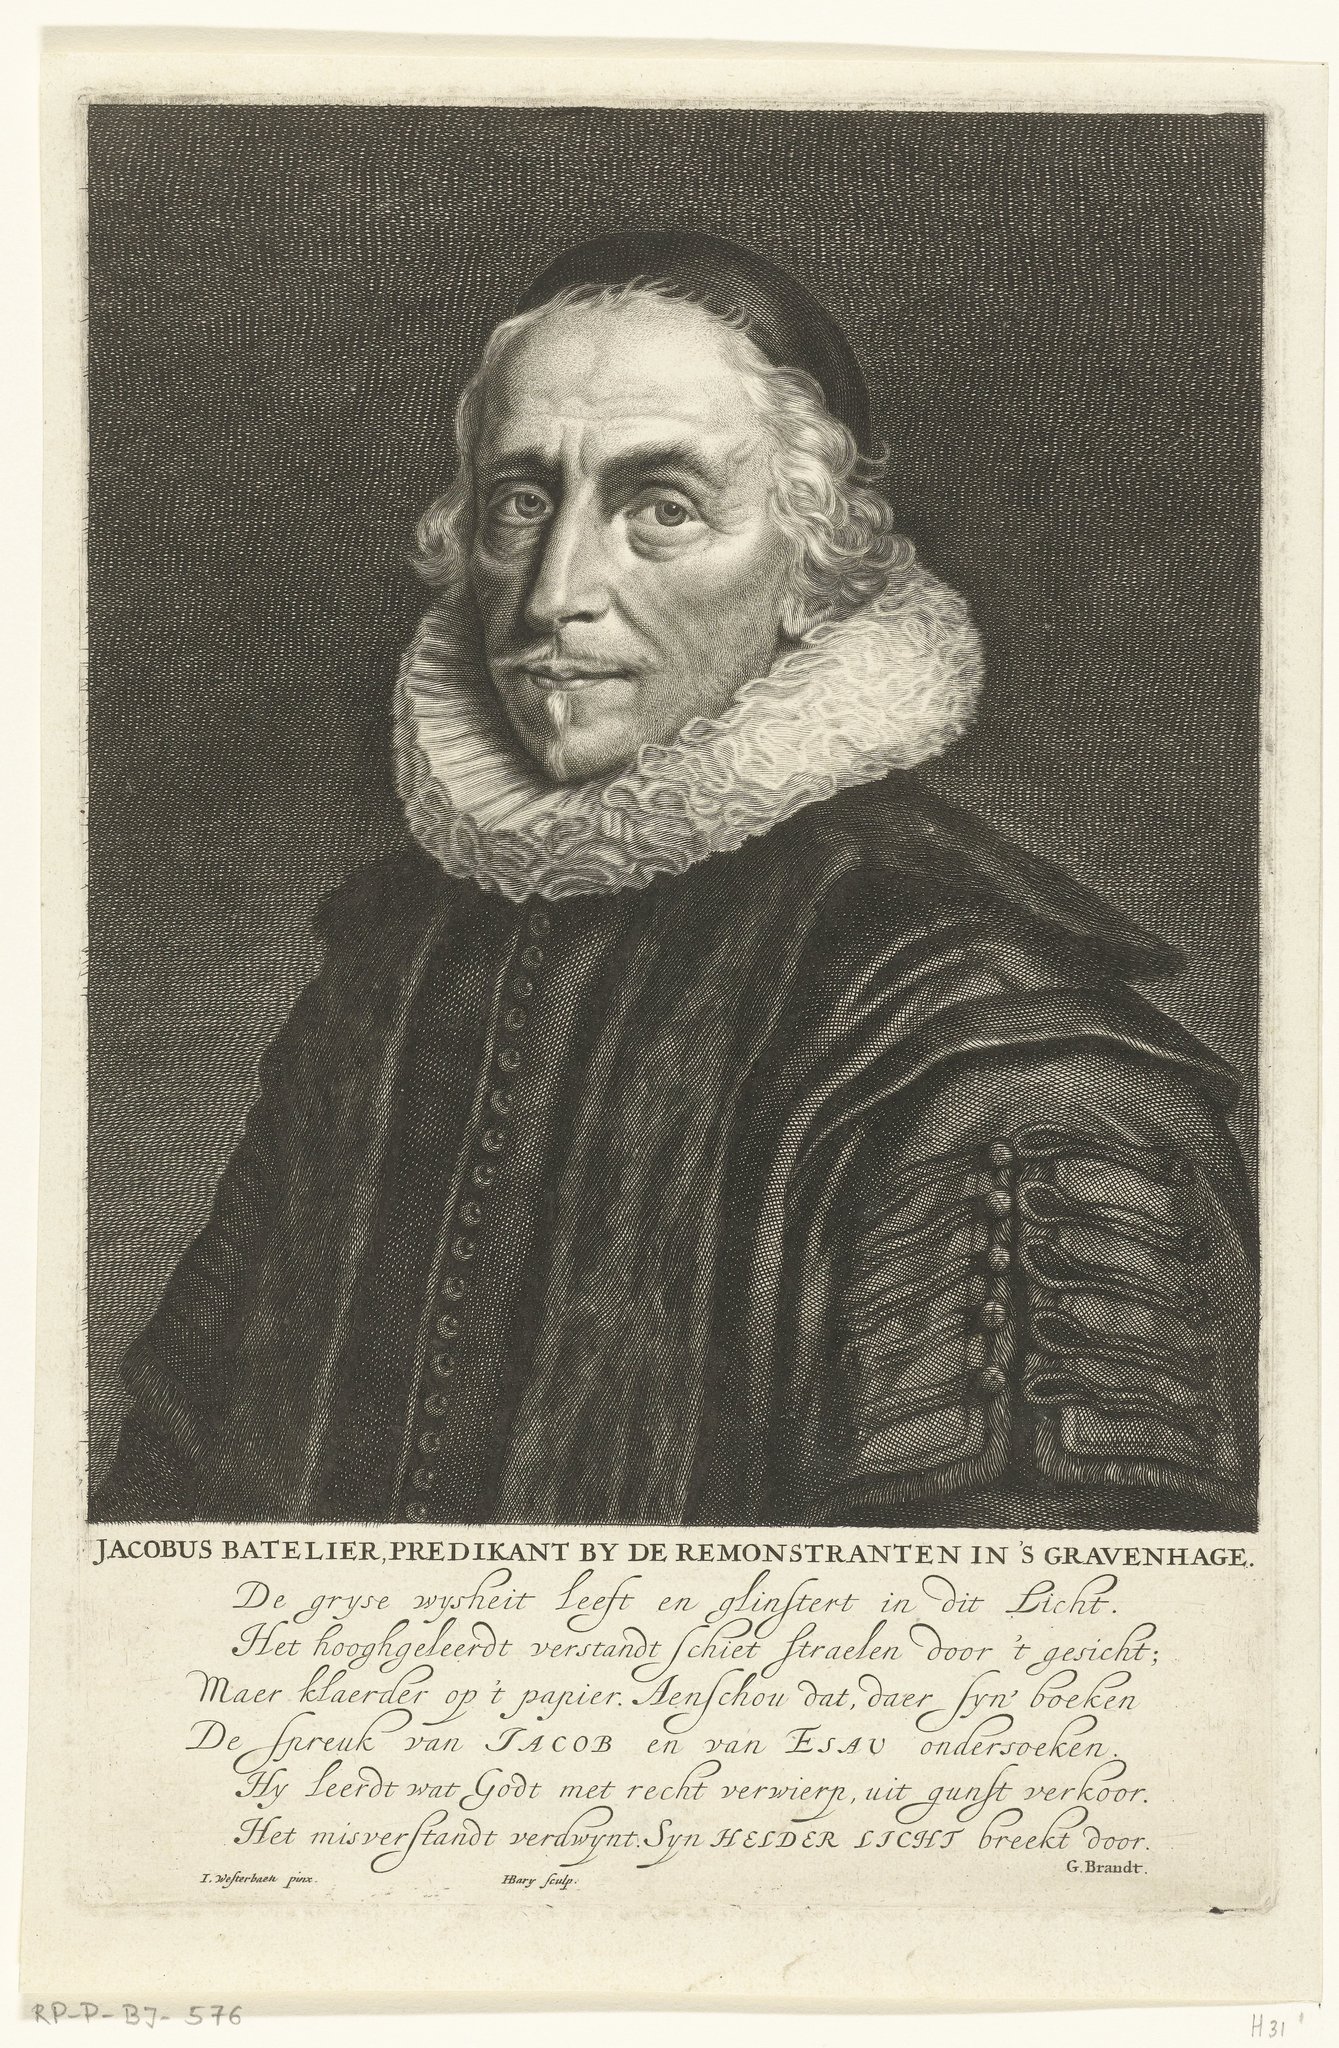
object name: print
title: Portret van Jacobus Johannes Batelier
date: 1657-1707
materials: paper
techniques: engraving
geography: netherlands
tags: predikant, jacobus johannes batelier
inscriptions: collector's mark: Lugt 2228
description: Portretbuste van de remonstrantse predikant Jacobus Johannes Batelier. Onder de voorstelling een vers van zes regels in het Nederlands.